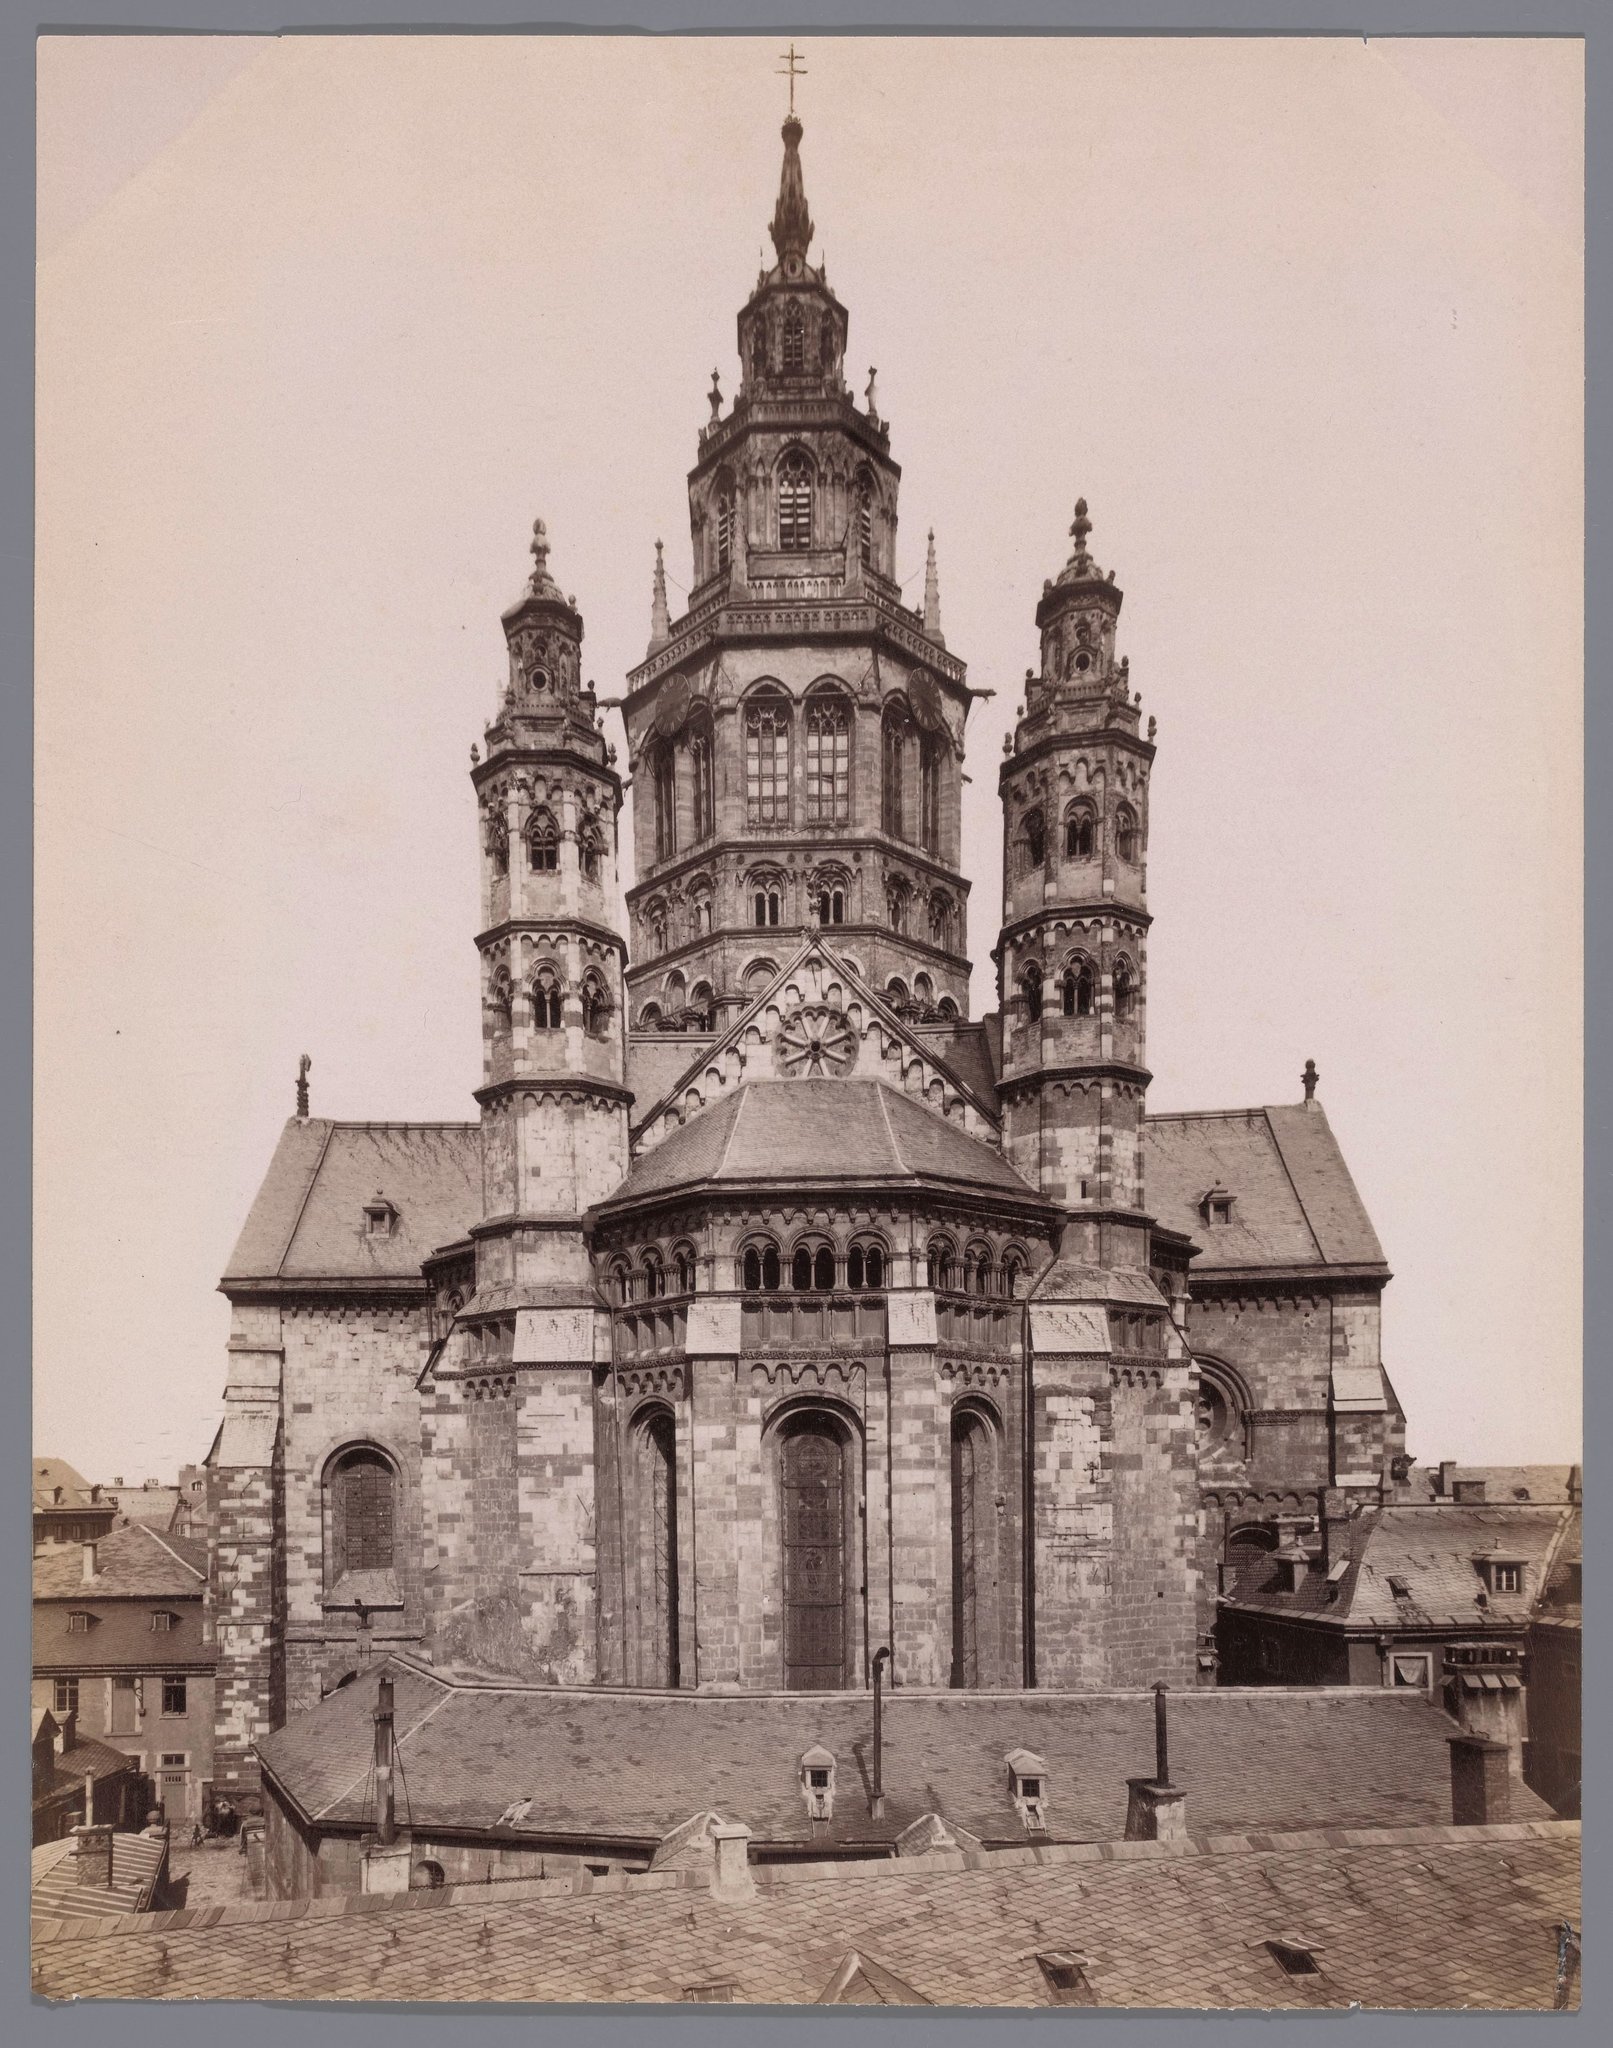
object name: photograph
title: Kerkgebouw in Neurenberg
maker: anselm schmitz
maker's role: publisher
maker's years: 1831-1903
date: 1880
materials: paper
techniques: albumen print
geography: nuremberg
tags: church (exterior)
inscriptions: inscription: ‘Anselm Schmitz K. Hof-Photograph in Cöln1880.’, number: ‘15’, inscription: ‘Nürnberg’